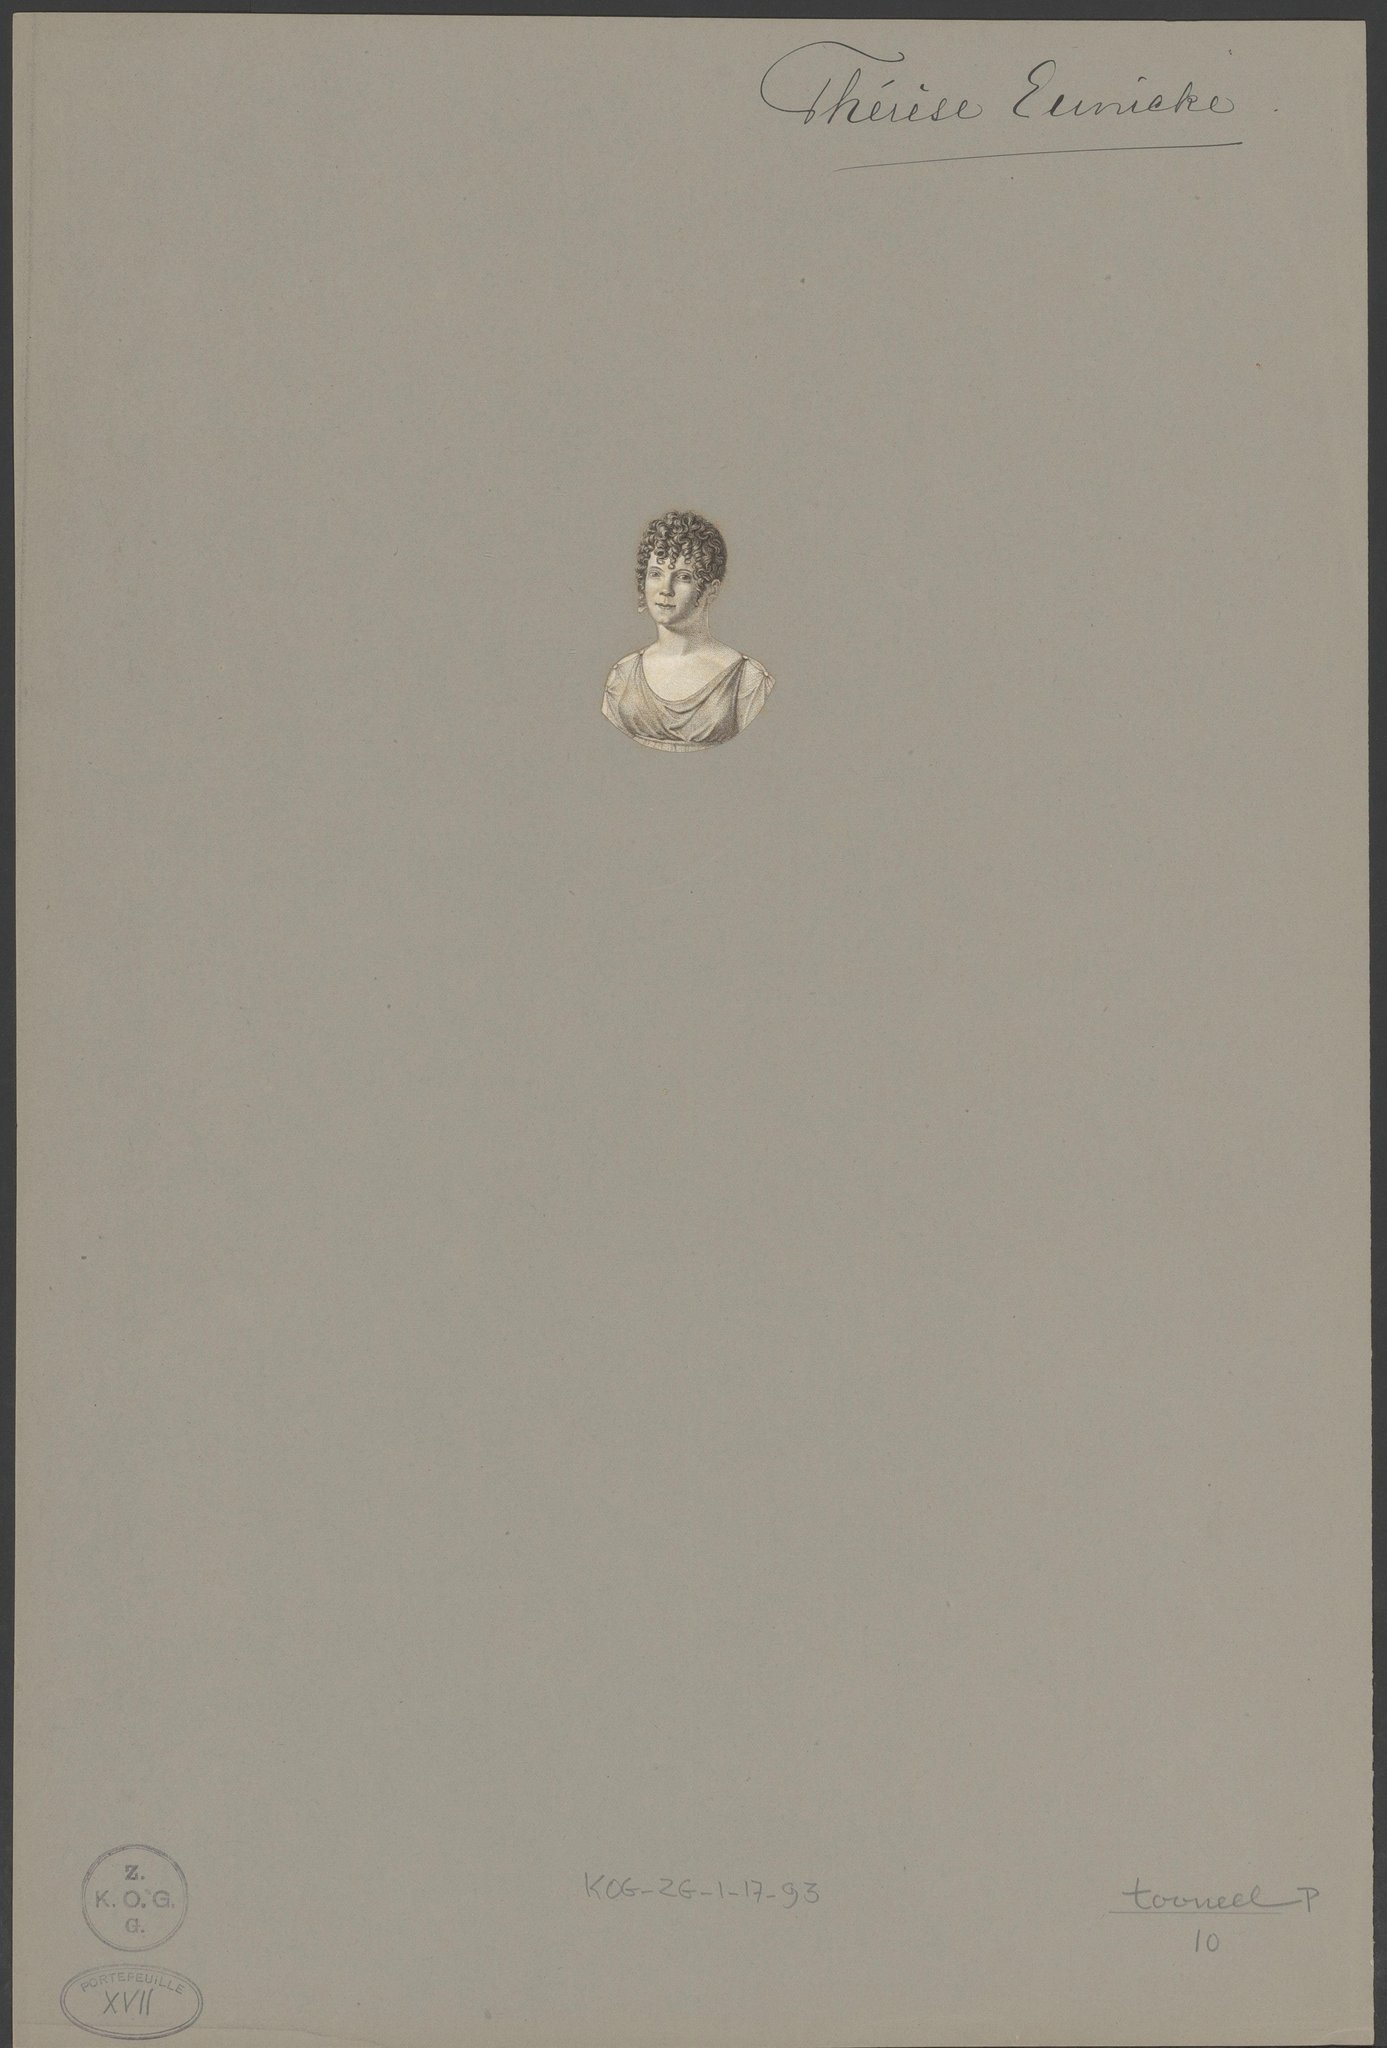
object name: print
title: Portret van Therese Eunicke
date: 1789-1850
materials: paper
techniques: etching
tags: stage costume, historical persons - bb - woman, actor (on the stage)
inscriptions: stamp, collector's mark: Lugt 1641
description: Onderwerpsrubrieken binnen de Atlas Zeden en Gewoonten: Tooneel, Portretten van toneelspelers.